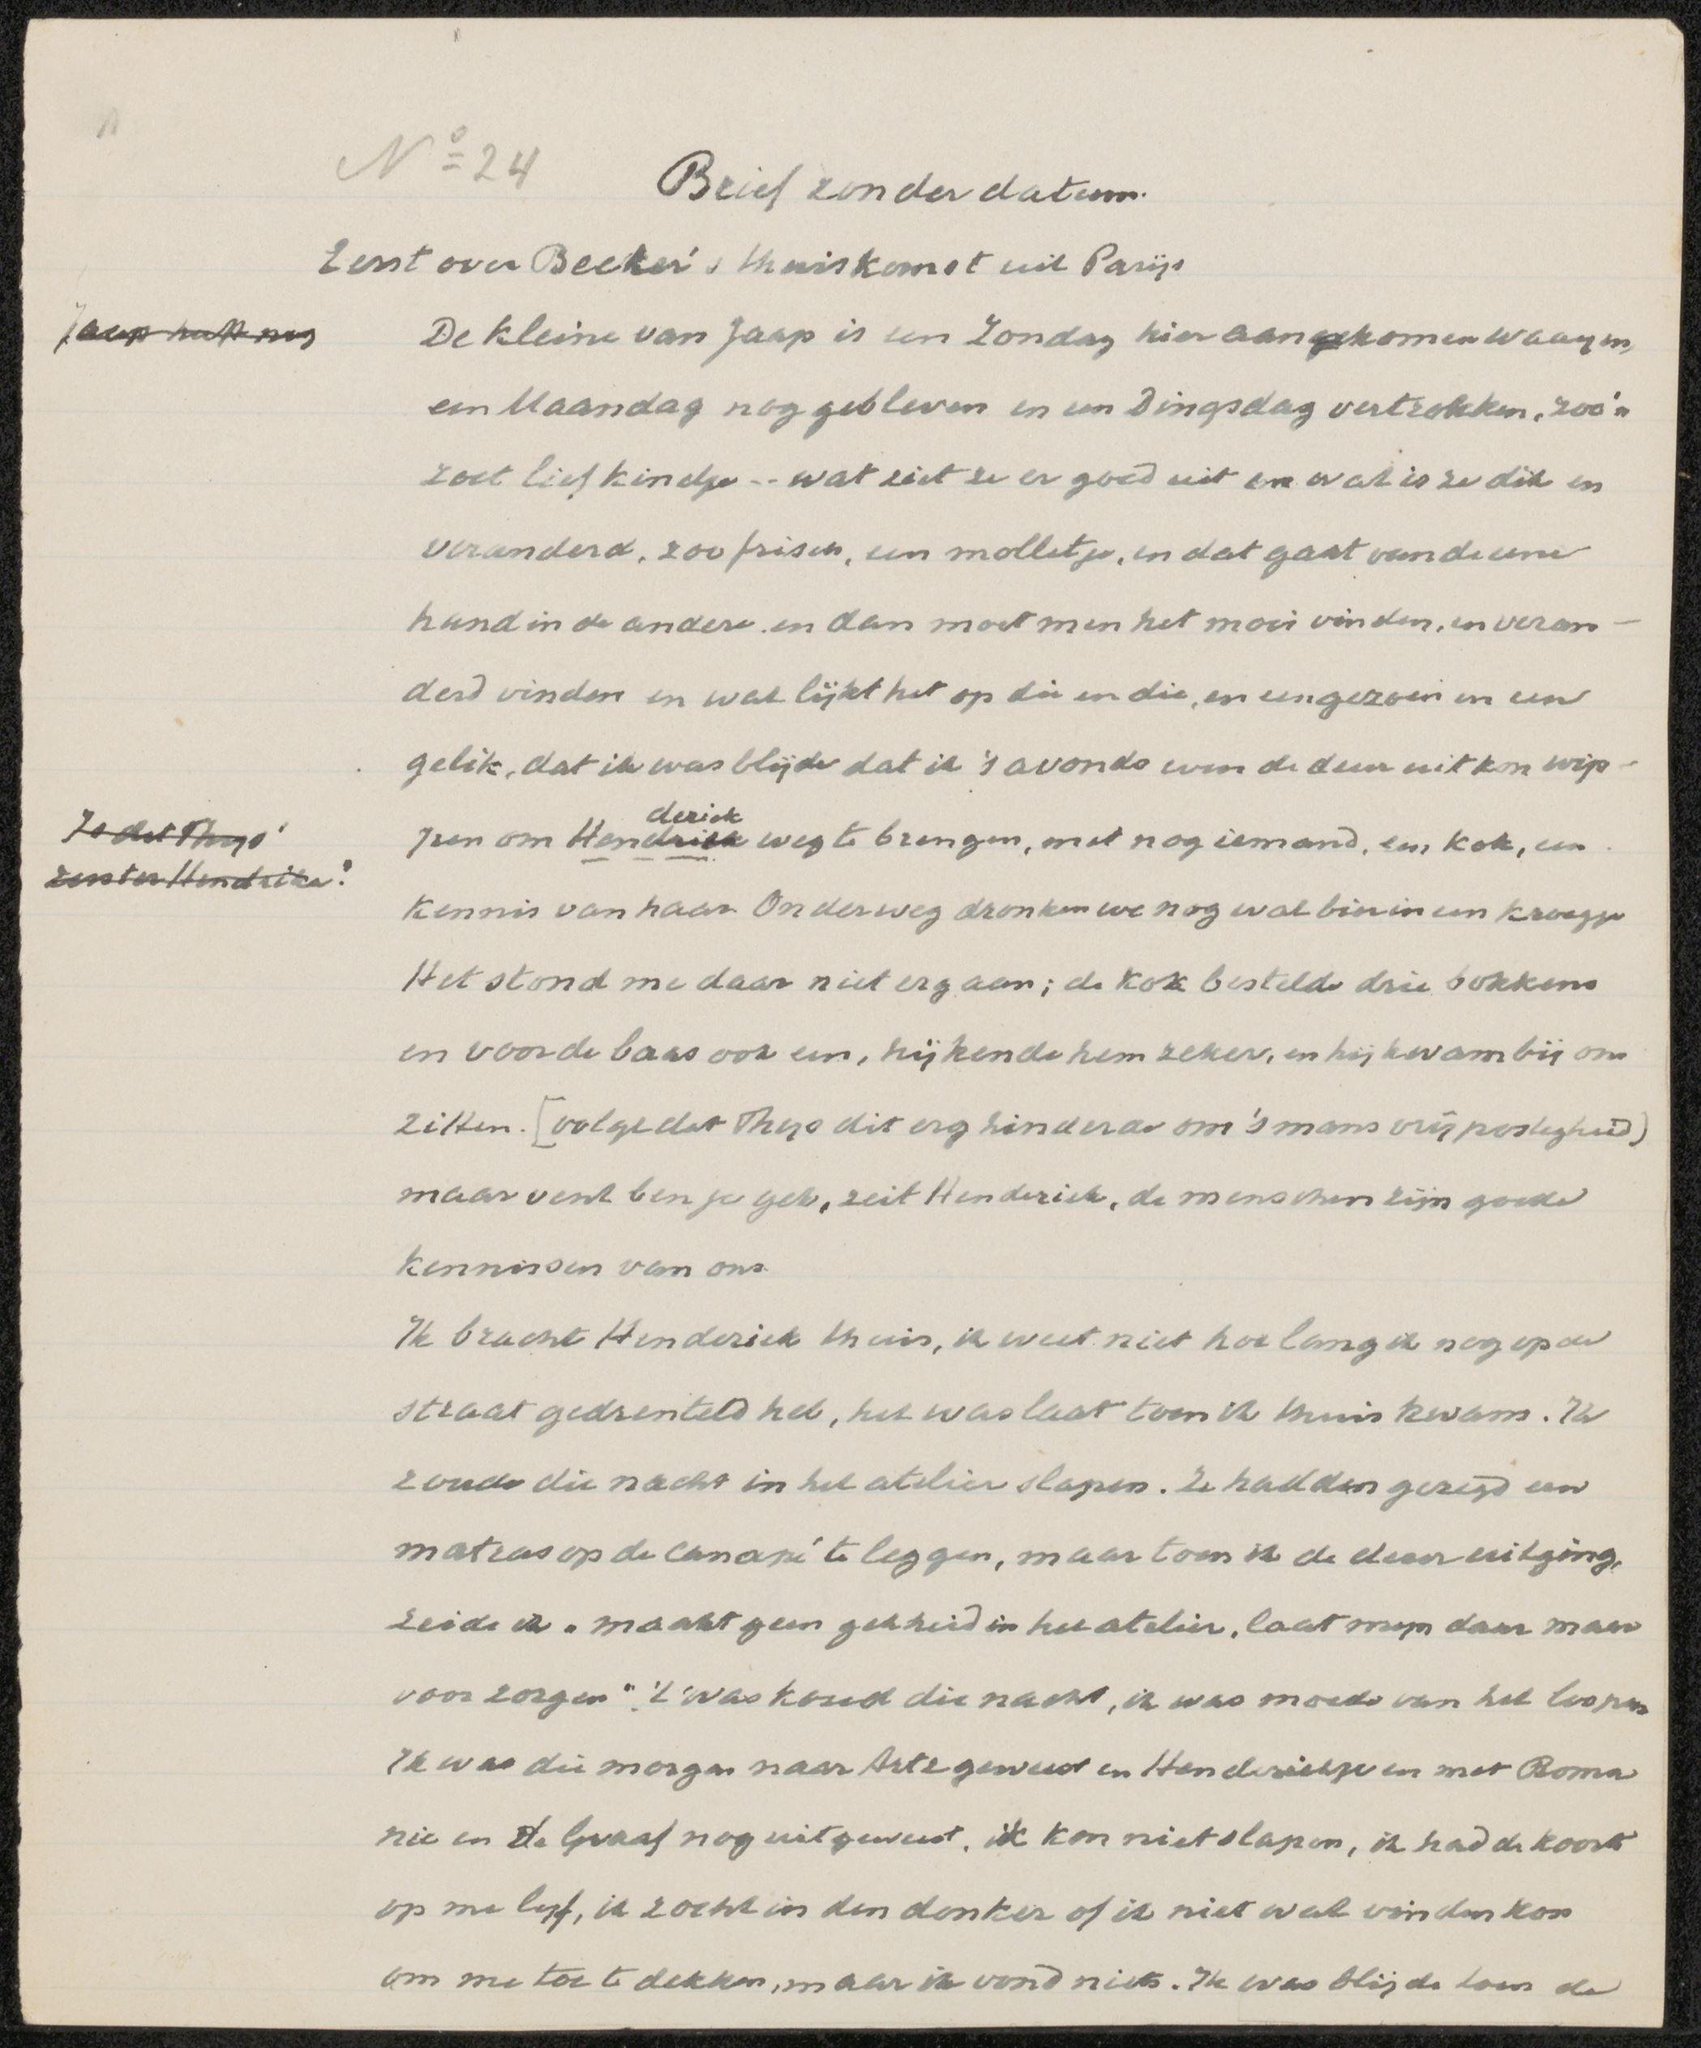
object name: letter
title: Geannoteerde transcriptie van een brief aan Fridolin Becker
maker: pieter haverkorn van rijsewijk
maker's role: museumdirecteur, publicist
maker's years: 1839-1919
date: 1869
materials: ink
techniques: pen, writing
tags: print maker, fridolin becker, jacob maris, the hague, draughtsman, david adolph constant artz, family life, workshop, studio of the artist (in general), money, paris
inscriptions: collector's mark: Lugt 2233